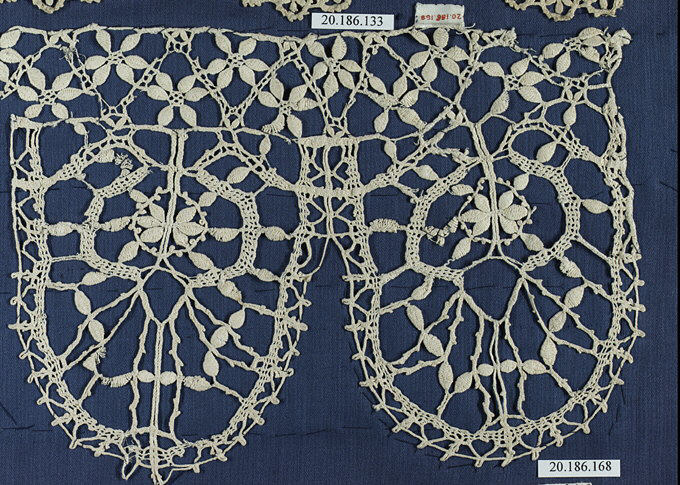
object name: edging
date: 1601-1700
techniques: lace